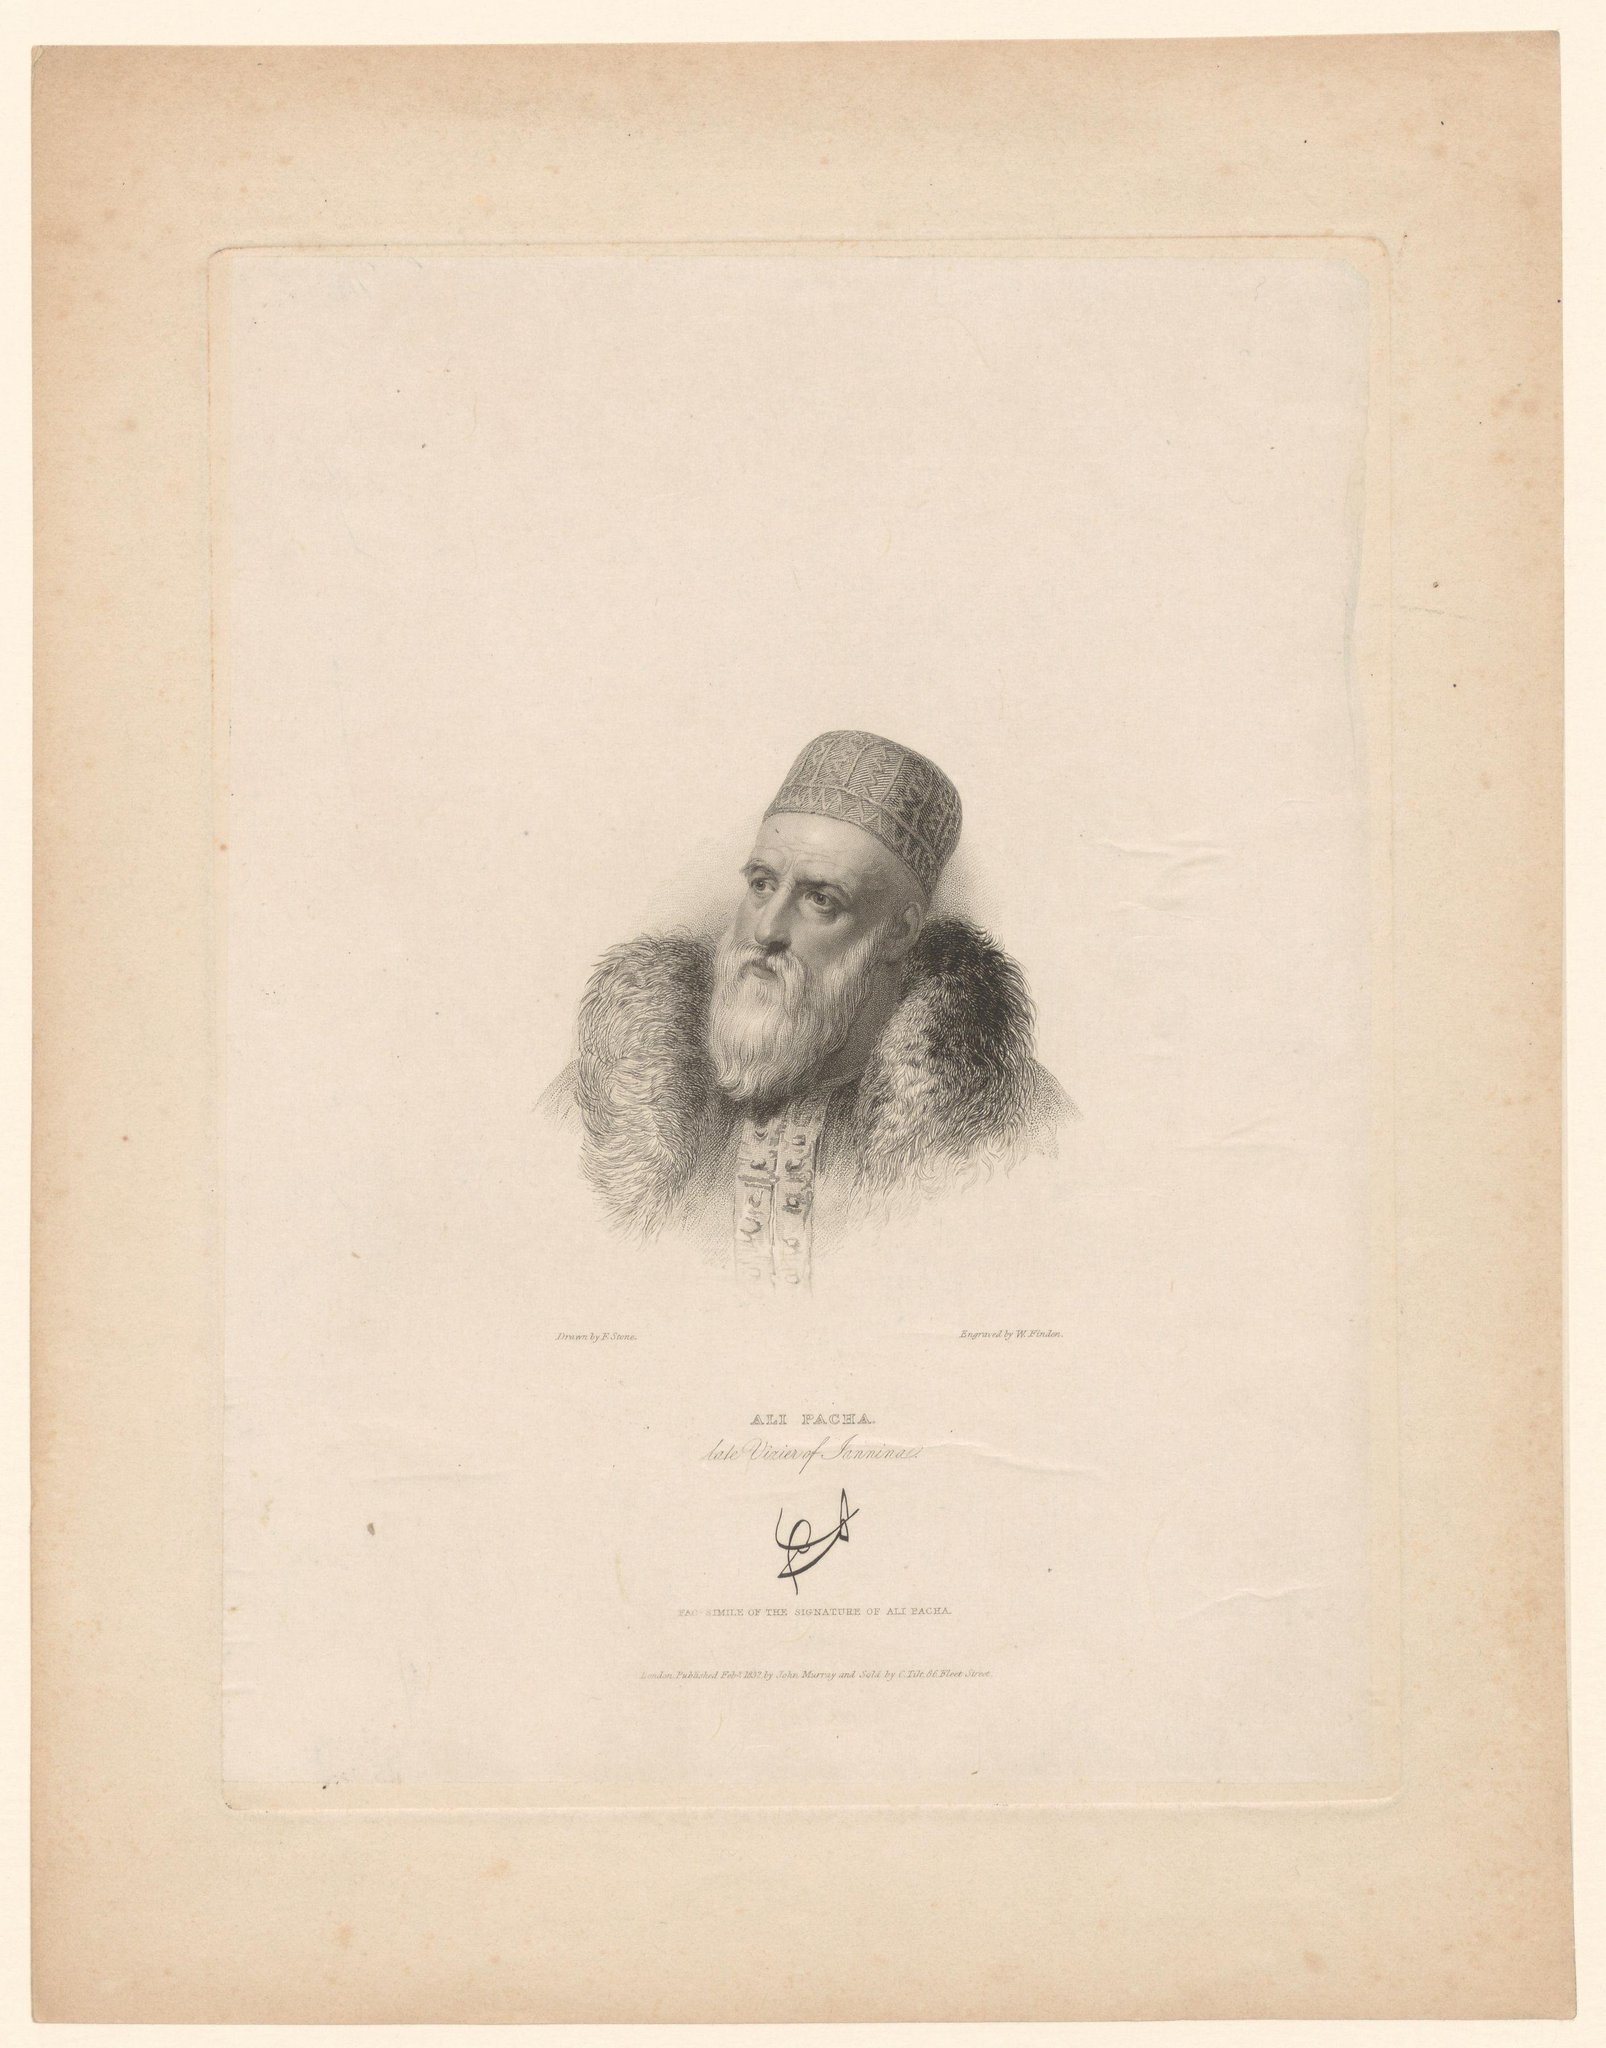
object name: print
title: Portret van Ali Pasja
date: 1832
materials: paper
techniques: engraving, etching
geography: london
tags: historical persons, officer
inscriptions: collector's mark: Lugt 2228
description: Een facsimile signatuur in de ondermarge.